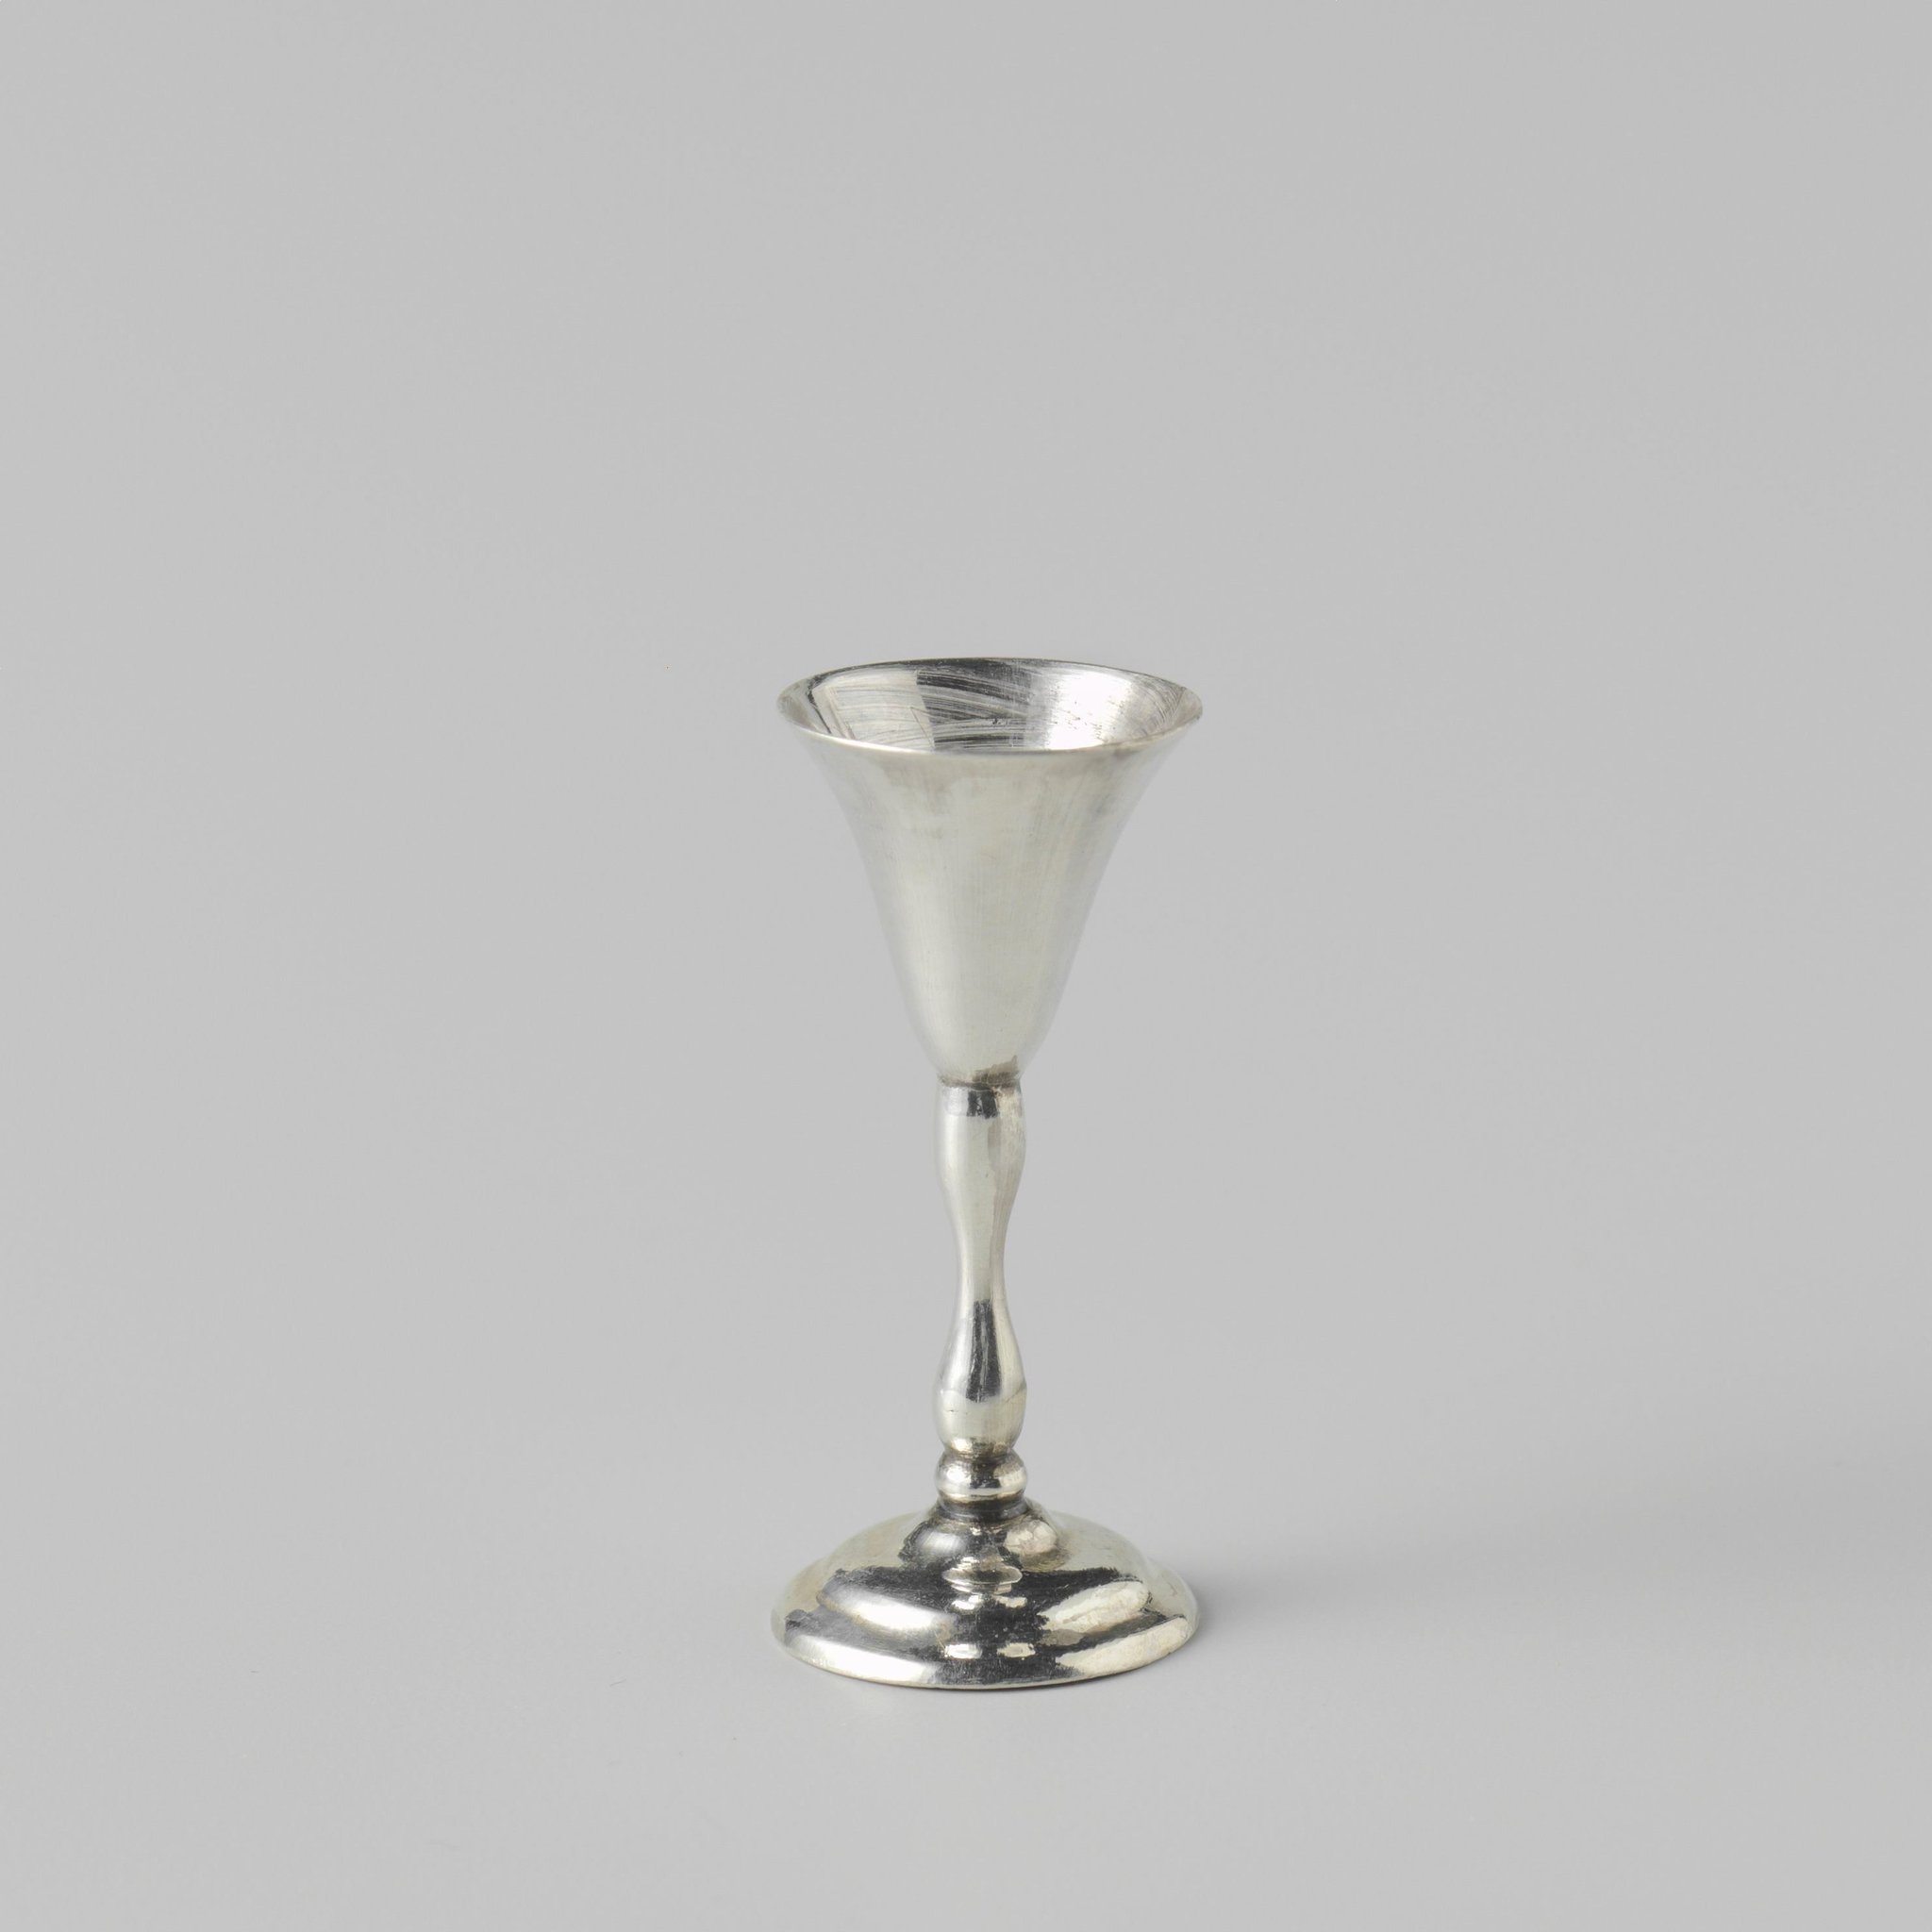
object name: miniature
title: Drinkglas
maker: Anonymous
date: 1725-1775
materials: silver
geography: netherlands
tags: glass, rummer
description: Trechtervormig drinkglas op een hoge balustervormige stam. De voet is rond en gewelfd. Het drinkglas is gelijk aan vijf andere exemplaren (BK-NM-11177-181-b-IV, BK-NM-11177-181-b-V, BK-NM-11177-181-b-VI, BK-NM-11177-181-b-VII, BK-NM-11177-181-b-VIII). De ddrinkglazen staan met een schenkkan (BK-NM-11177-181-b-II) op een dienblad (BK-NM-11177-181-b-I). Het dienblad staat op een klaptafel (BK-NM-11177-181-a).